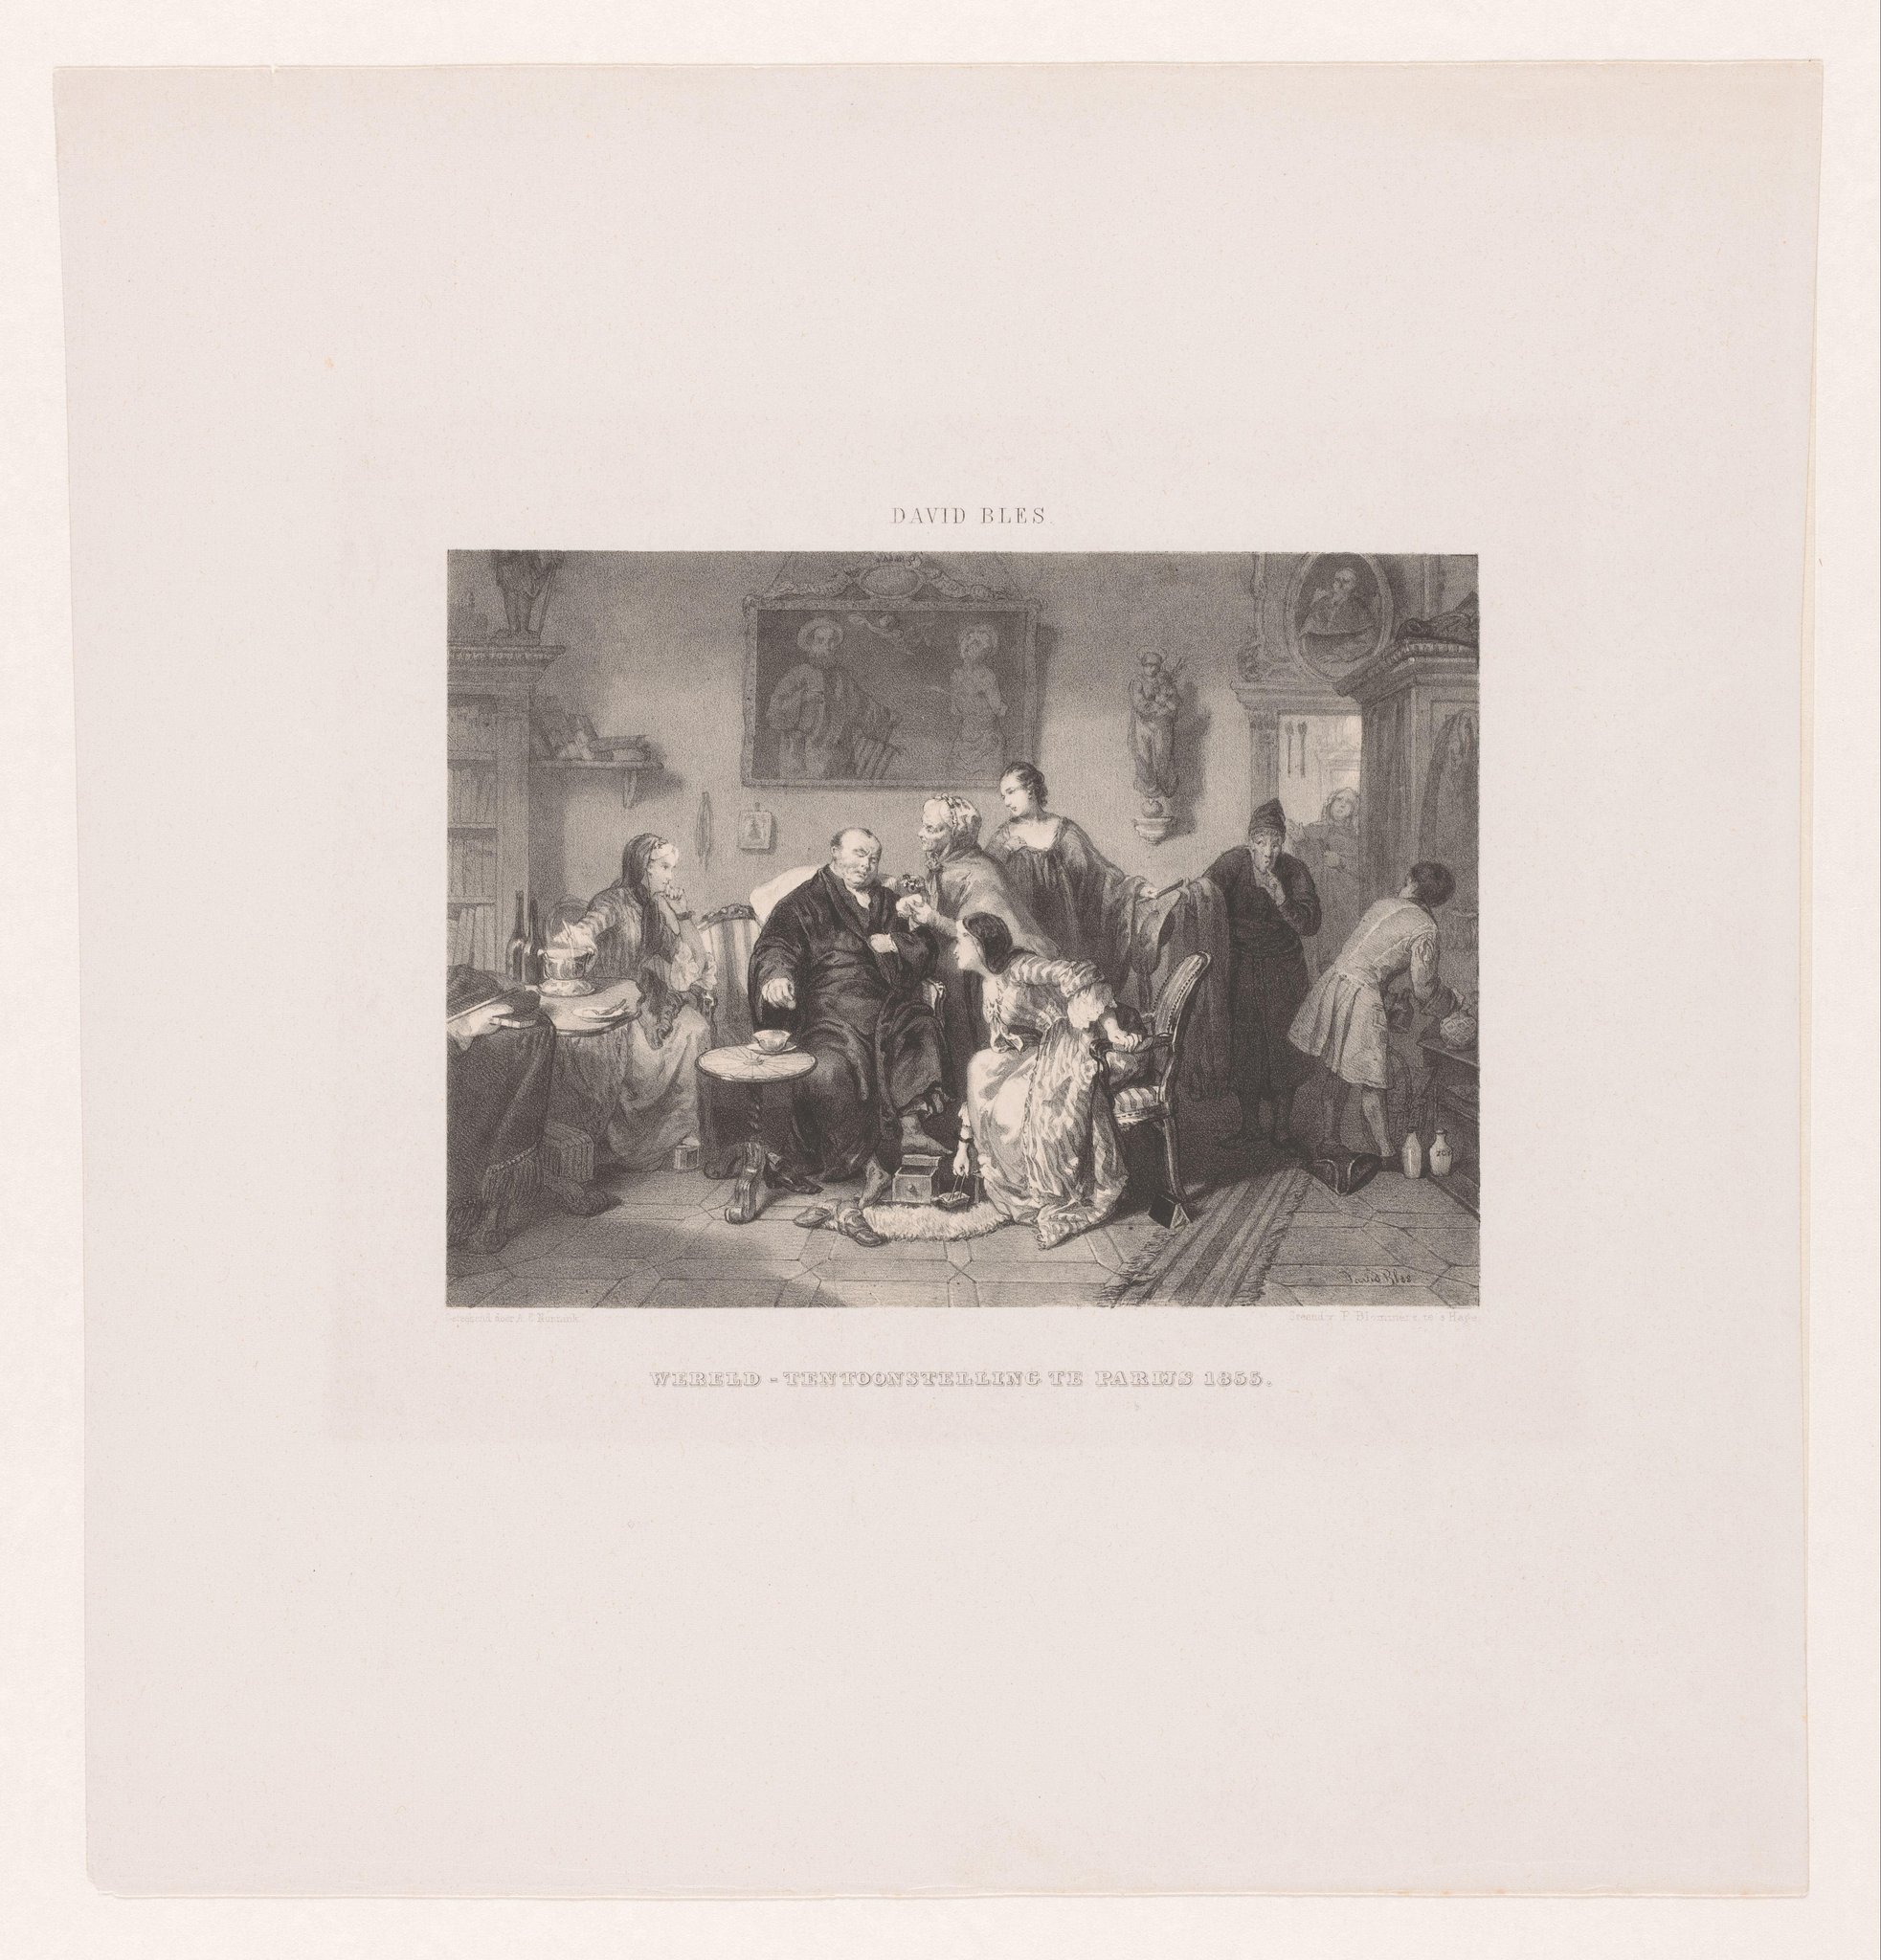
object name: print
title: Gewaande zieke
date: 1856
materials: paper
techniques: lithograph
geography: the hague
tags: person feigning illness, nursing, tending the sick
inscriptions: collector's mark: Lugt 2228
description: Prent naar Directeur de Femmes (ook wel Le Malade imaginaire, De gewaande zieke, The simulator) van David Bles. Bles schilderde in 1848-1849 meerdere schilderijen met dit onderwerp naar een scène uit het toneelstuk De ingebeelde zieke van Molière (1673). Prent uit Kunstkronijk, 1856.